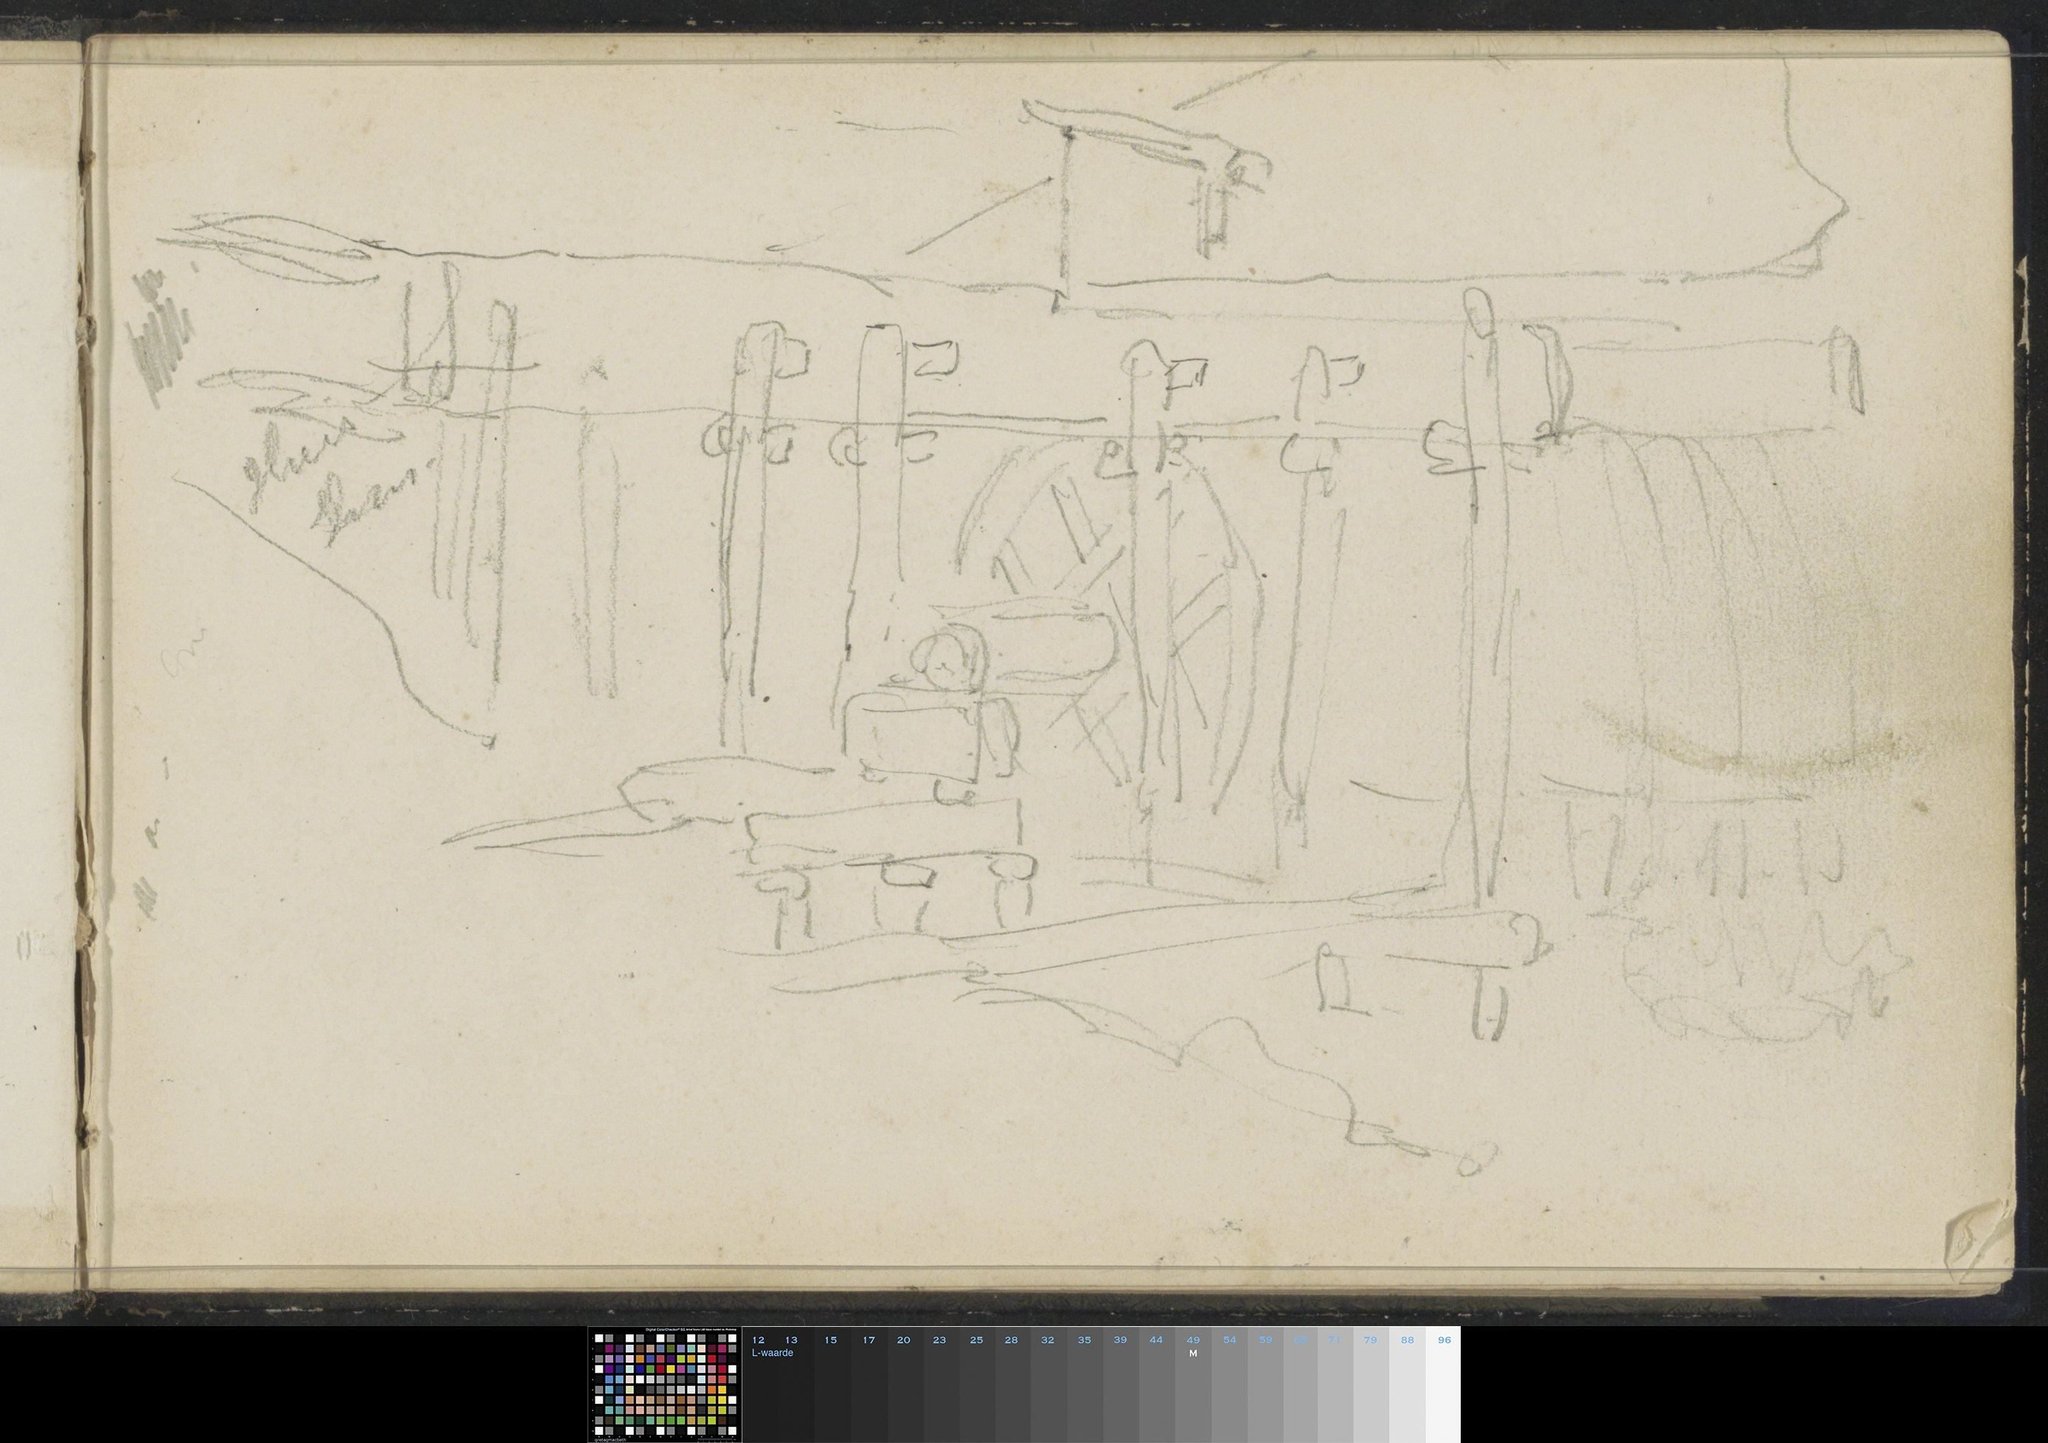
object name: sketchbook leaf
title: Constructie met een rad, mogelijk een watermolen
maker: cornelis springer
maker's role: draughtsman, painter, print maker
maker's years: 1817-1891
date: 1869-1870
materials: paper, pencil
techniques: stumping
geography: woerden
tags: watermill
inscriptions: annotation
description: Constructie met een rad, mogelijk een watermolen. Blad 1 uit een schetsboek met 40 bladen, vervaardigd in Woerden en Gouda.